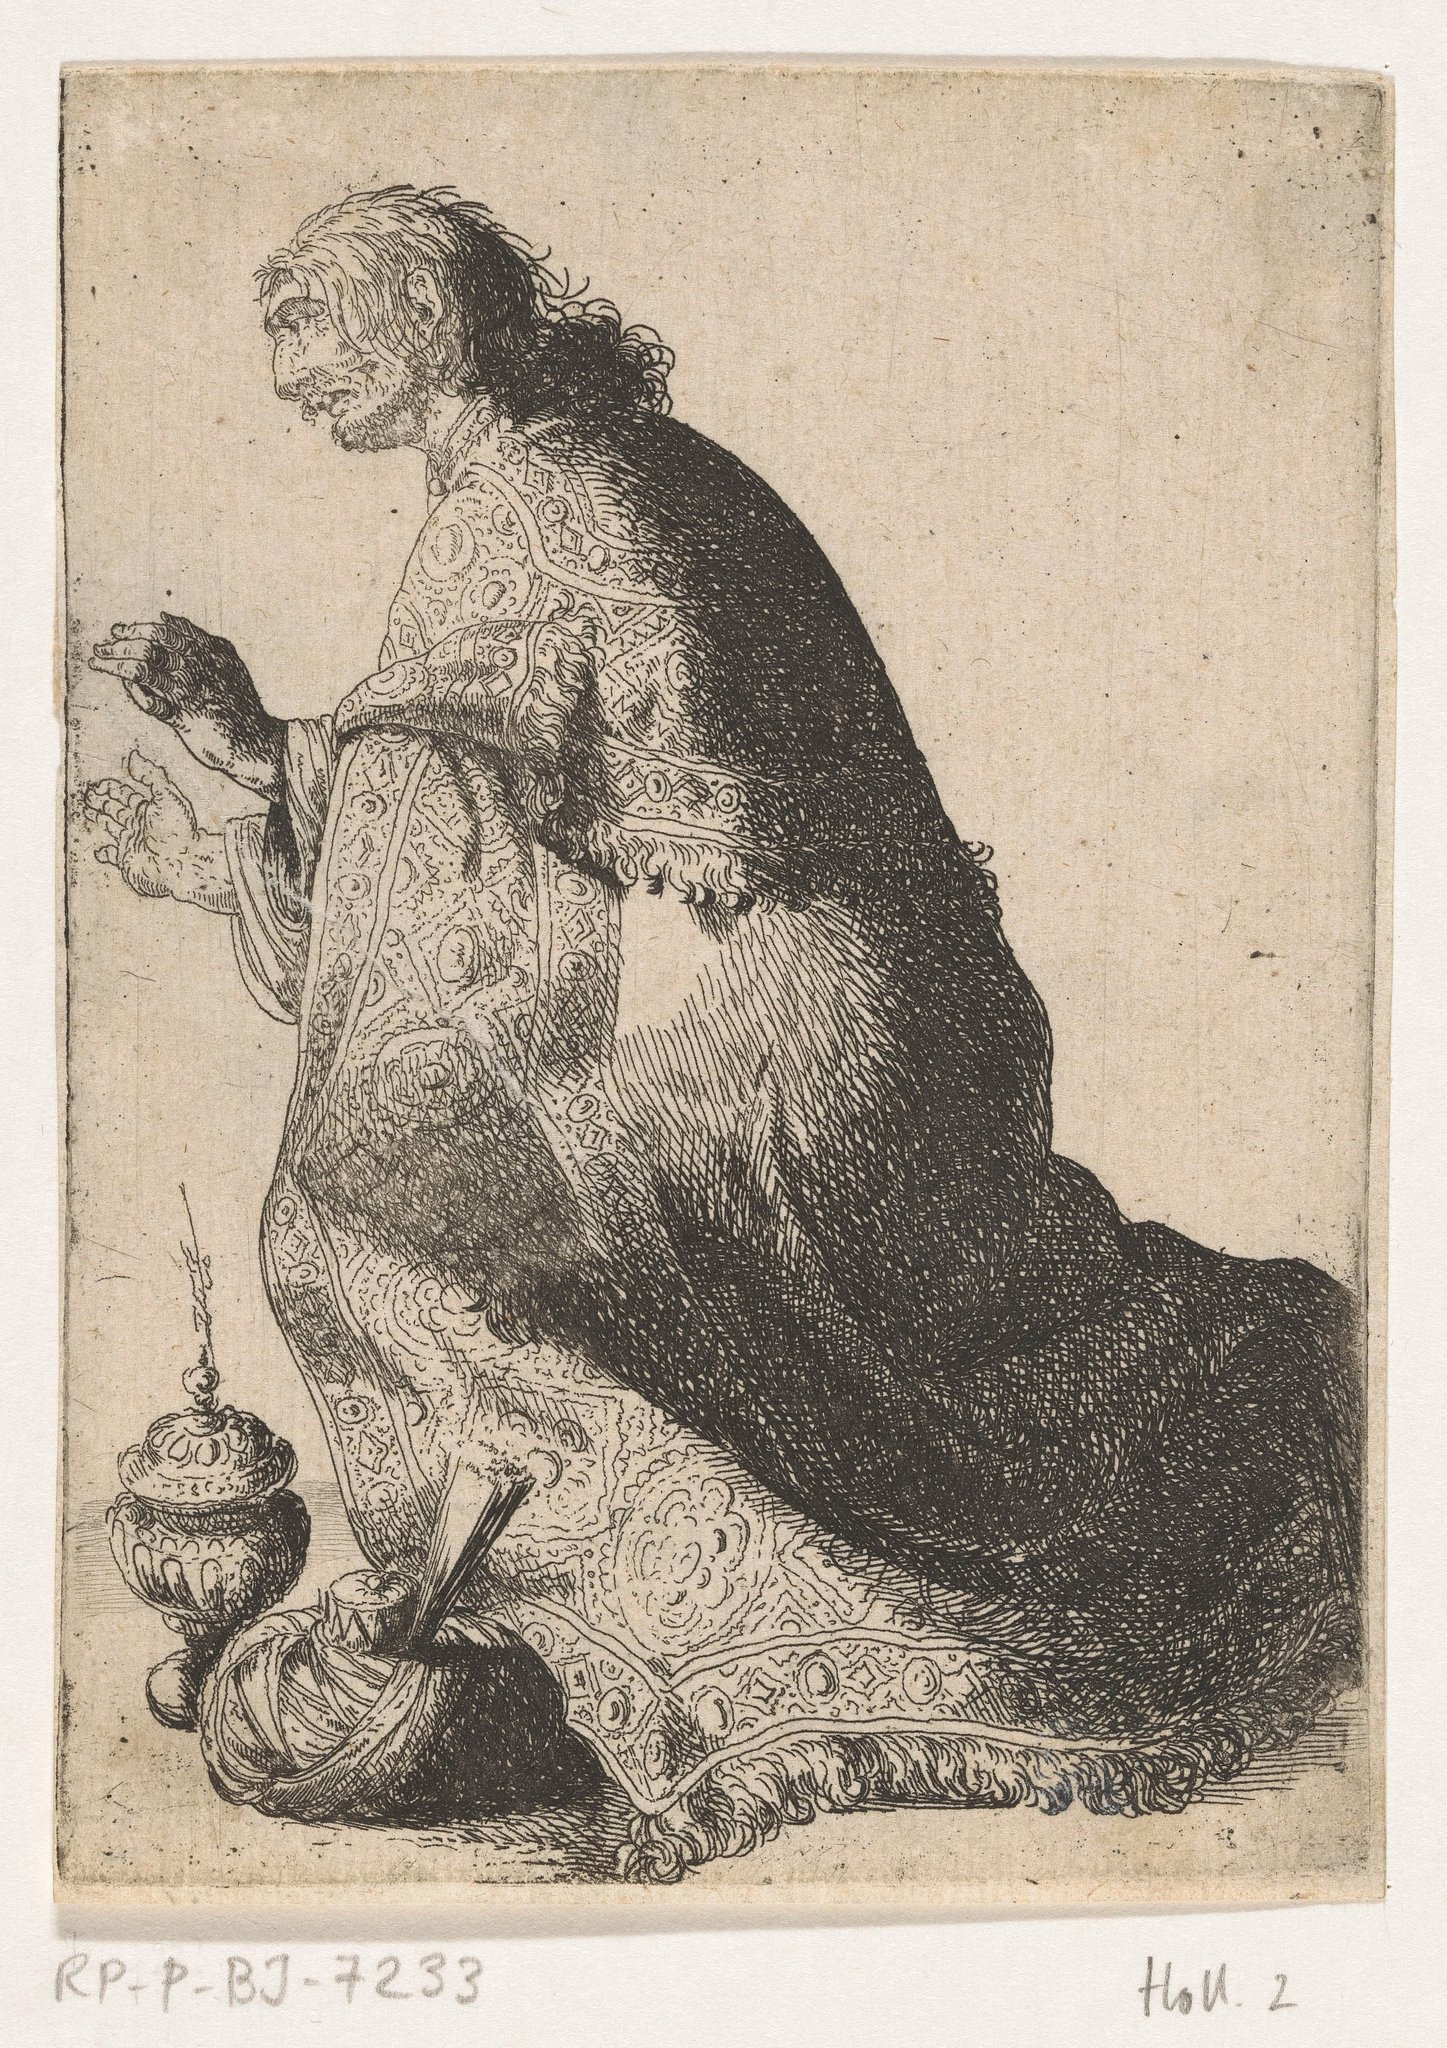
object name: print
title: Koning in aanbidding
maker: jacob duck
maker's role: draughtsman, painter, print maker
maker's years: 1600-1667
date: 1621-1667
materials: paper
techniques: etching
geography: utrecht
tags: adoration of the kings: the wise men present their gifts to the christ-child (gold, frankincense and myrrh)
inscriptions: collector's mark: Lugt 778, collector's mark: Lugt 2228